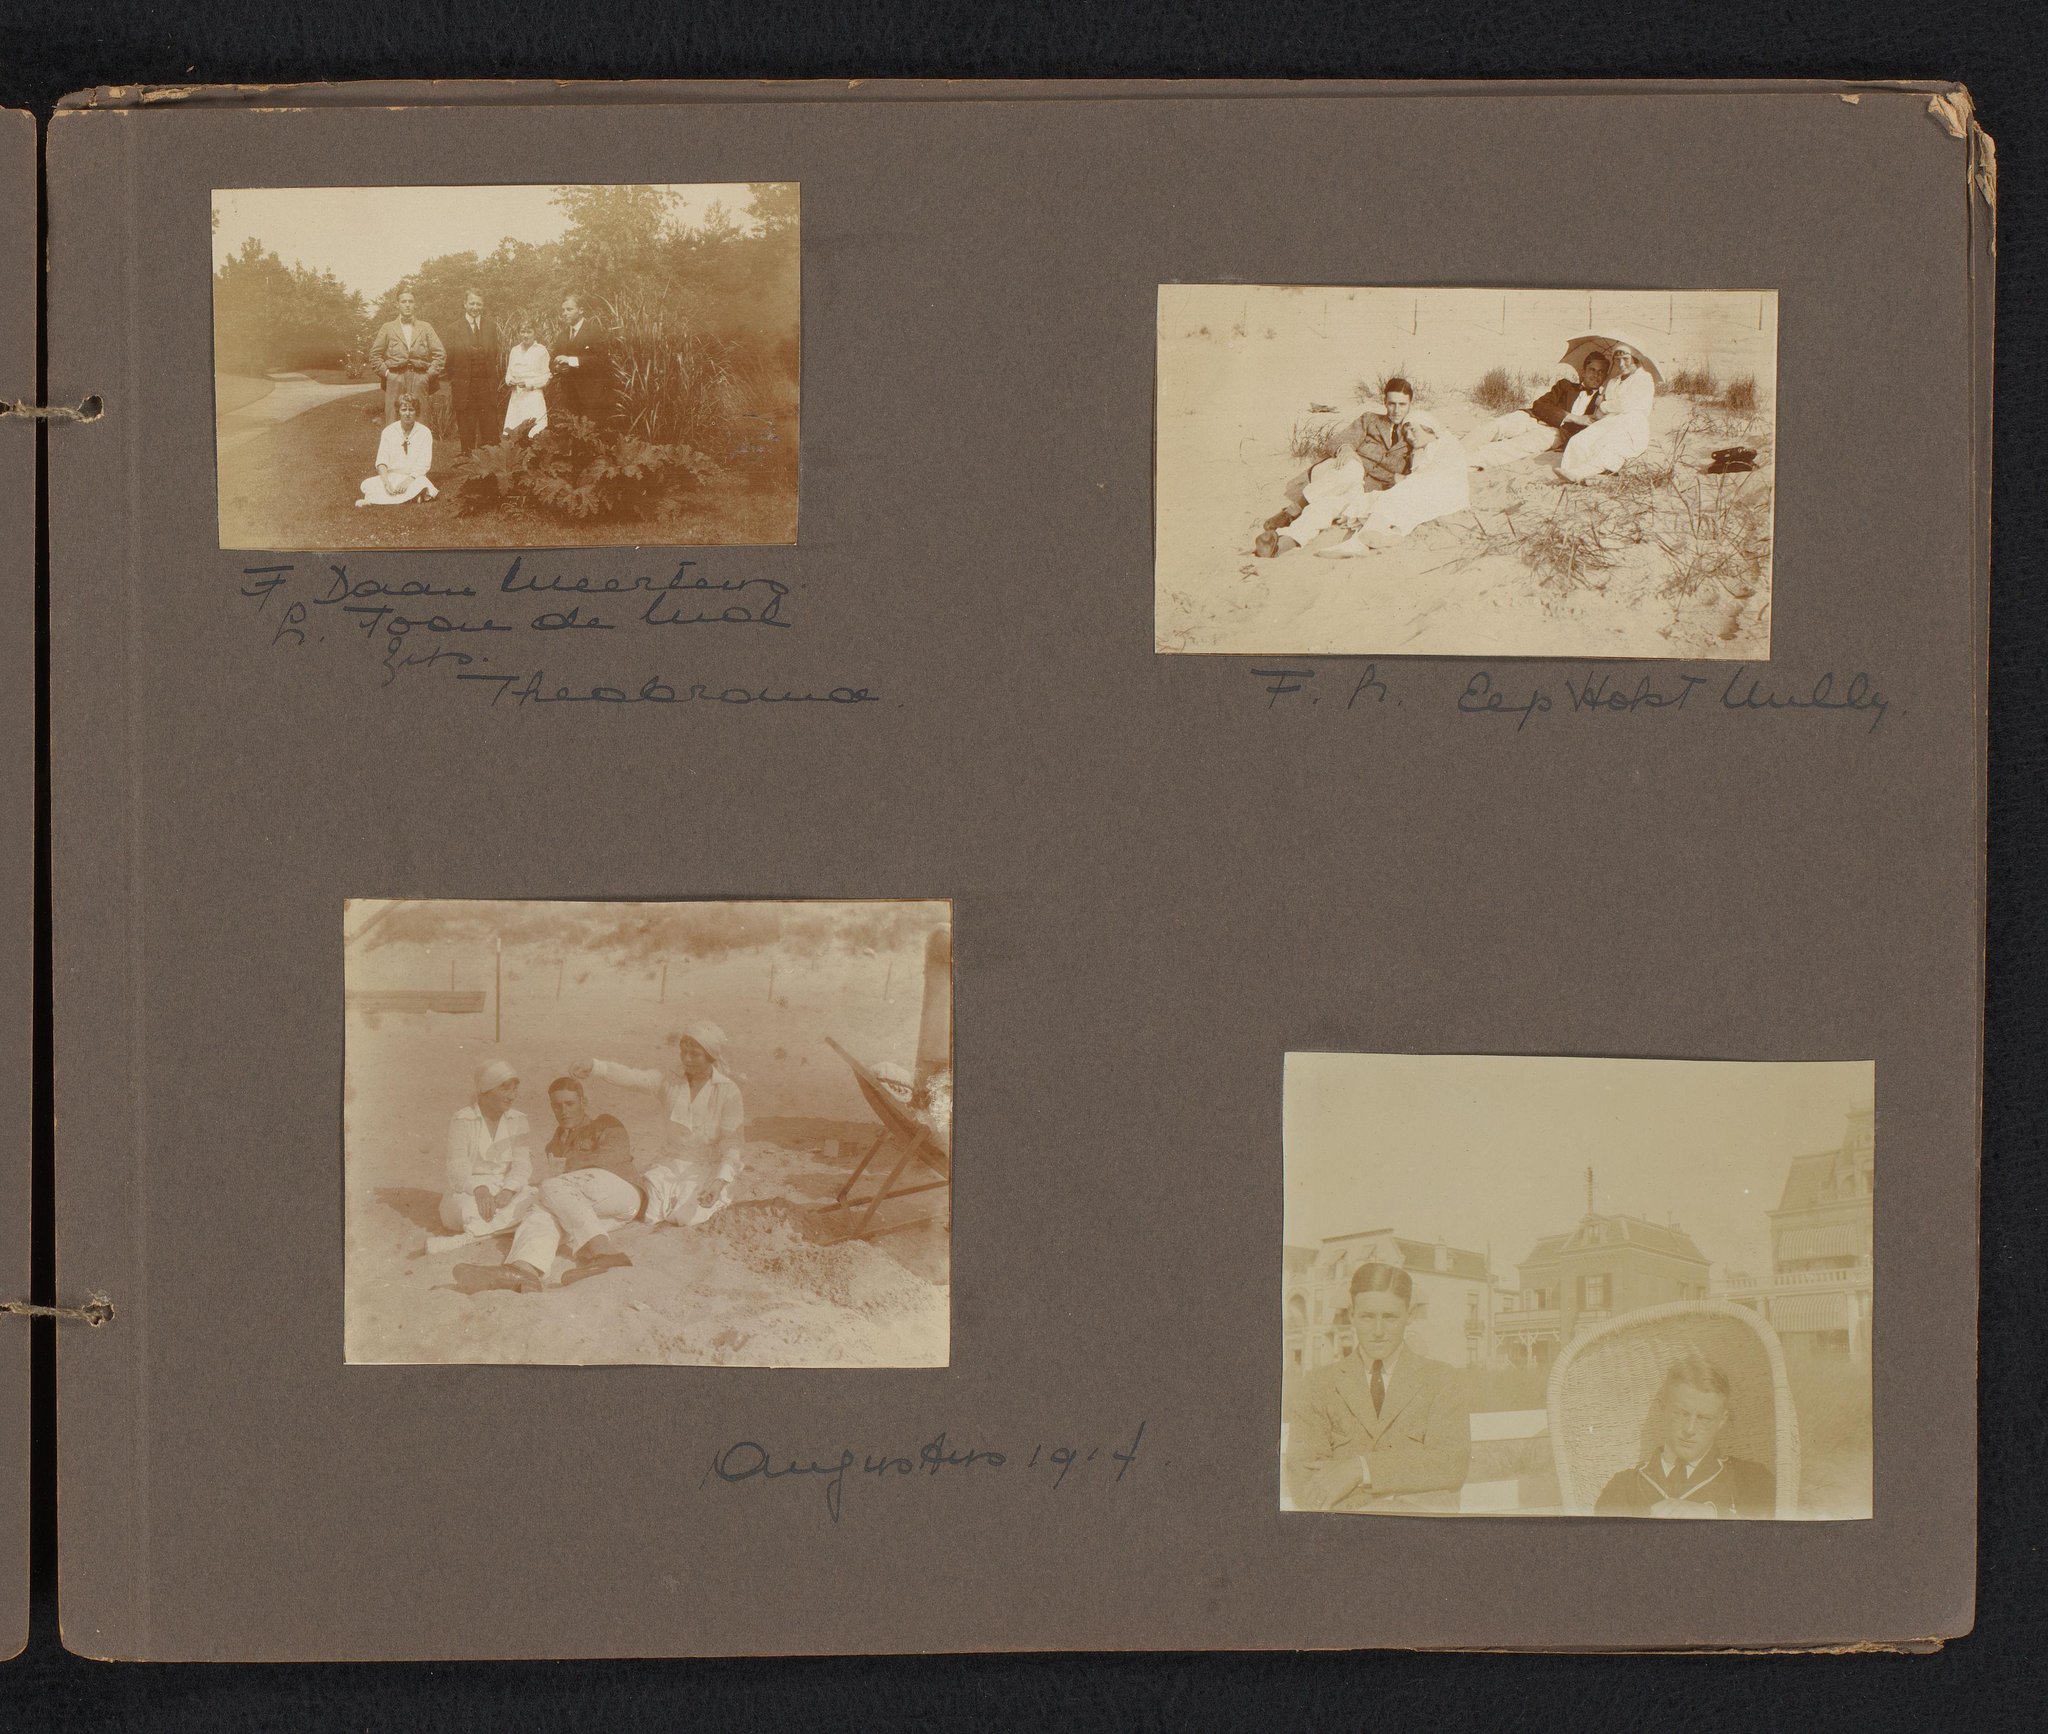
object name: album leaf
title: Vier foto's van vrienden van Loentje Onnen op het strand van Zandvoort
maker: carolina frederika onnen (lien/loen)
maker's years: 1896-1983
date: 1908-1914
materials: paper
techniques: gelatin silver print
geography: zandvoort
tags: beach (as place of recreation), sunbathing (on the beach), friends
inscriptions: inscription: ‘F. Gr. Eep Wolst [?] Milly’, inscription: ‘F. Daan Meertens/ L. Toon de Mol/ Zus./ Theobroma.’, inscription: ‘Augustus 1914’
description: Deze foto's maken deel uit van een album.